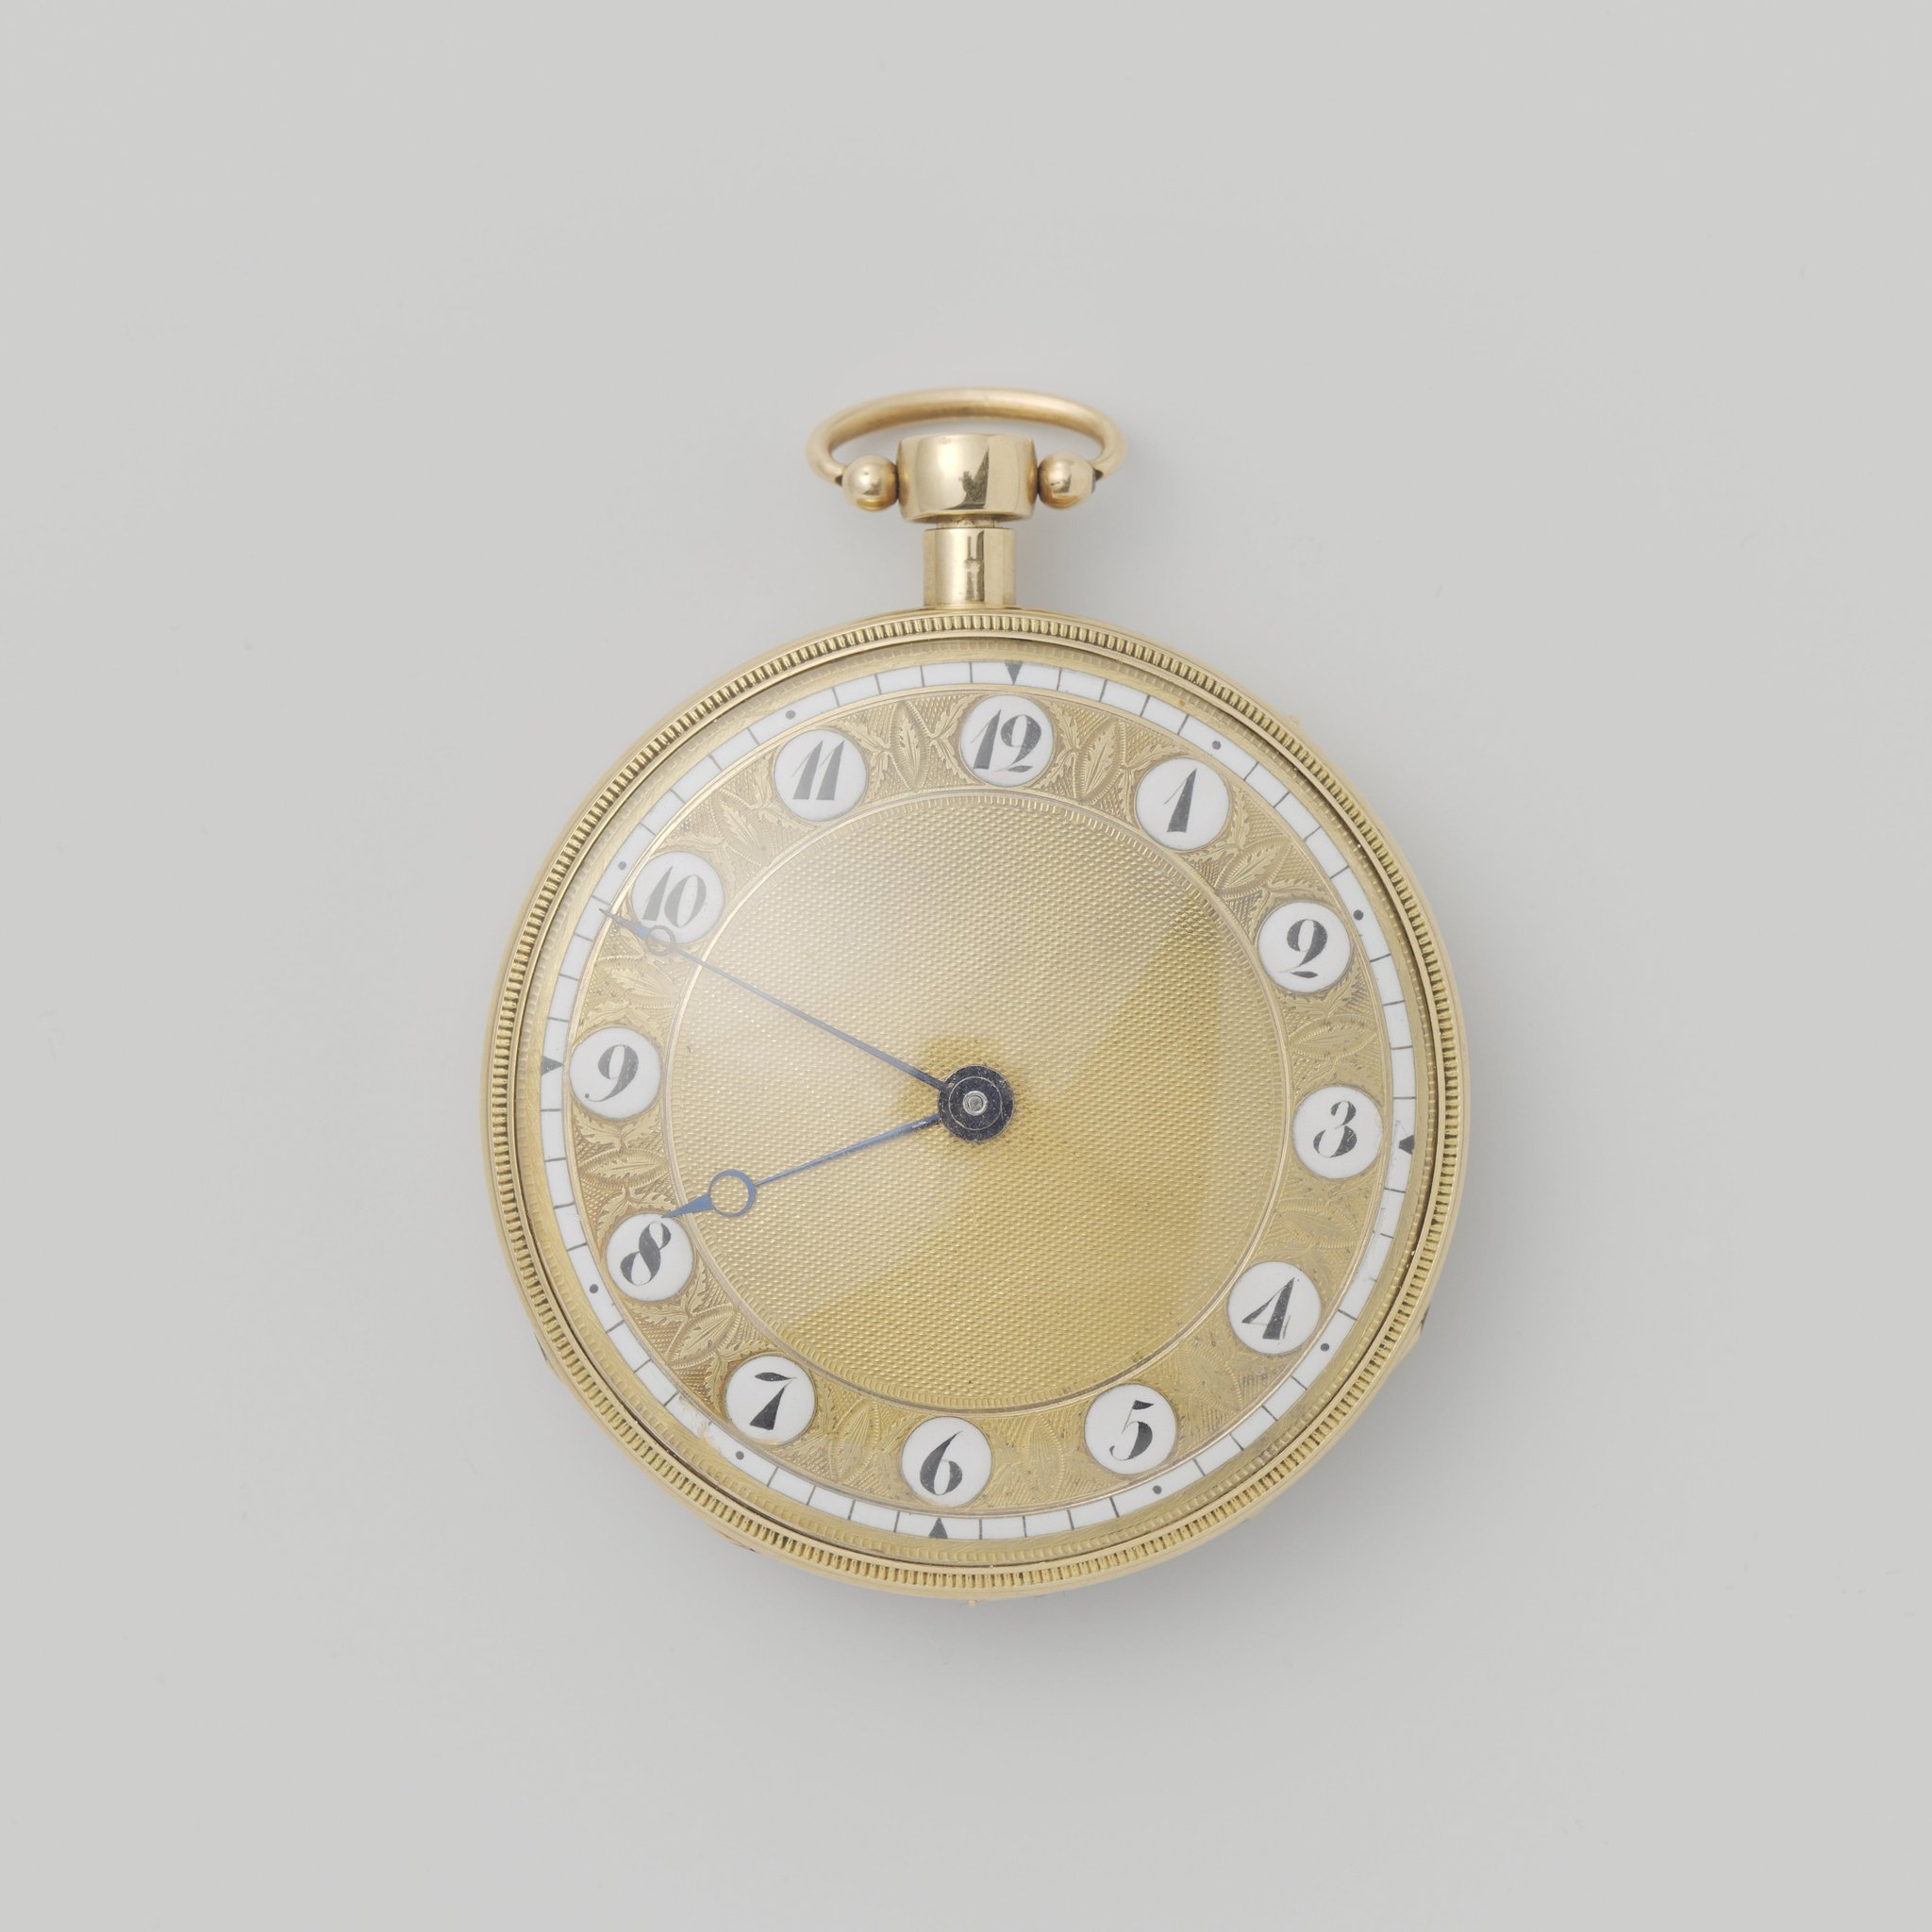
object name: jewellery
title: Repeating Watch with a Striking Mechanism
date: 1800-1815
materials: gold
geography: geneva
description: Herenhorloge van goud, kwartierrepetitie en waaierkamspeelwerk. Geguillocheerde achterdeksel.